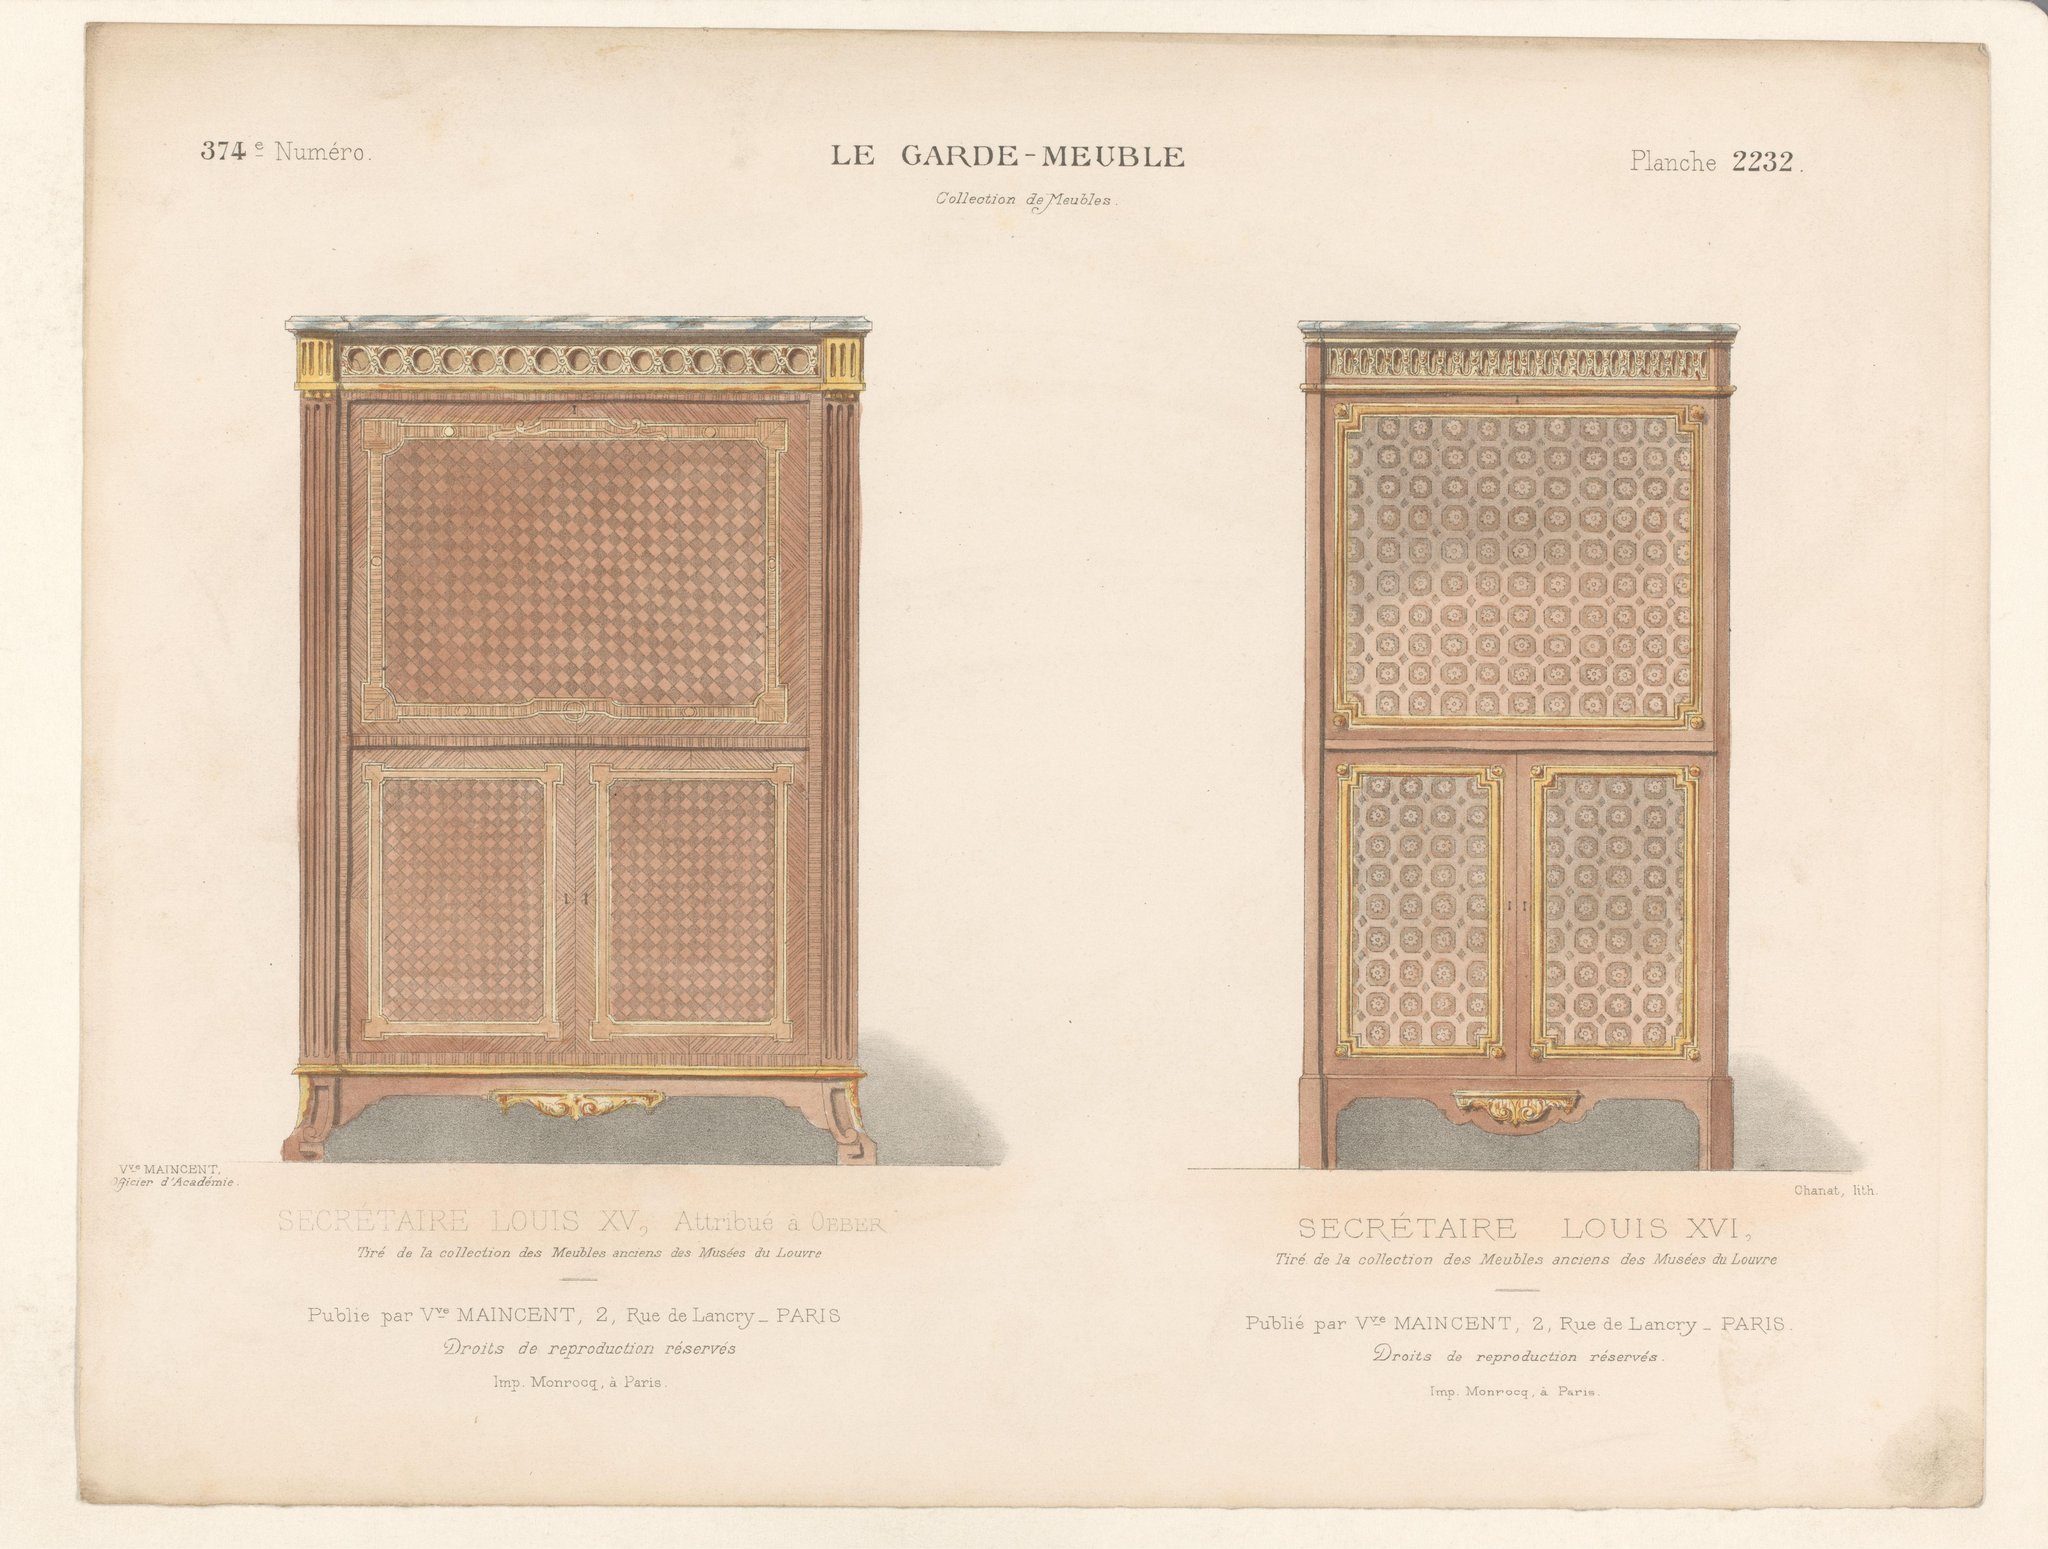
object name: print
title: Twee secretaires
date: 1895-1935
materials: paper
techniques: hand coloring, lithograph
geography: paris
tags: furniture for storage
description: Ieder Livraison in de serie Le Garde-Meuble bevat negen platen: drie 'sièges' (zitmeubels), drie 'meubles' (diverse meubels zoals tafels en kasten) en drie 'tentures' (gordijnen en draperieën).